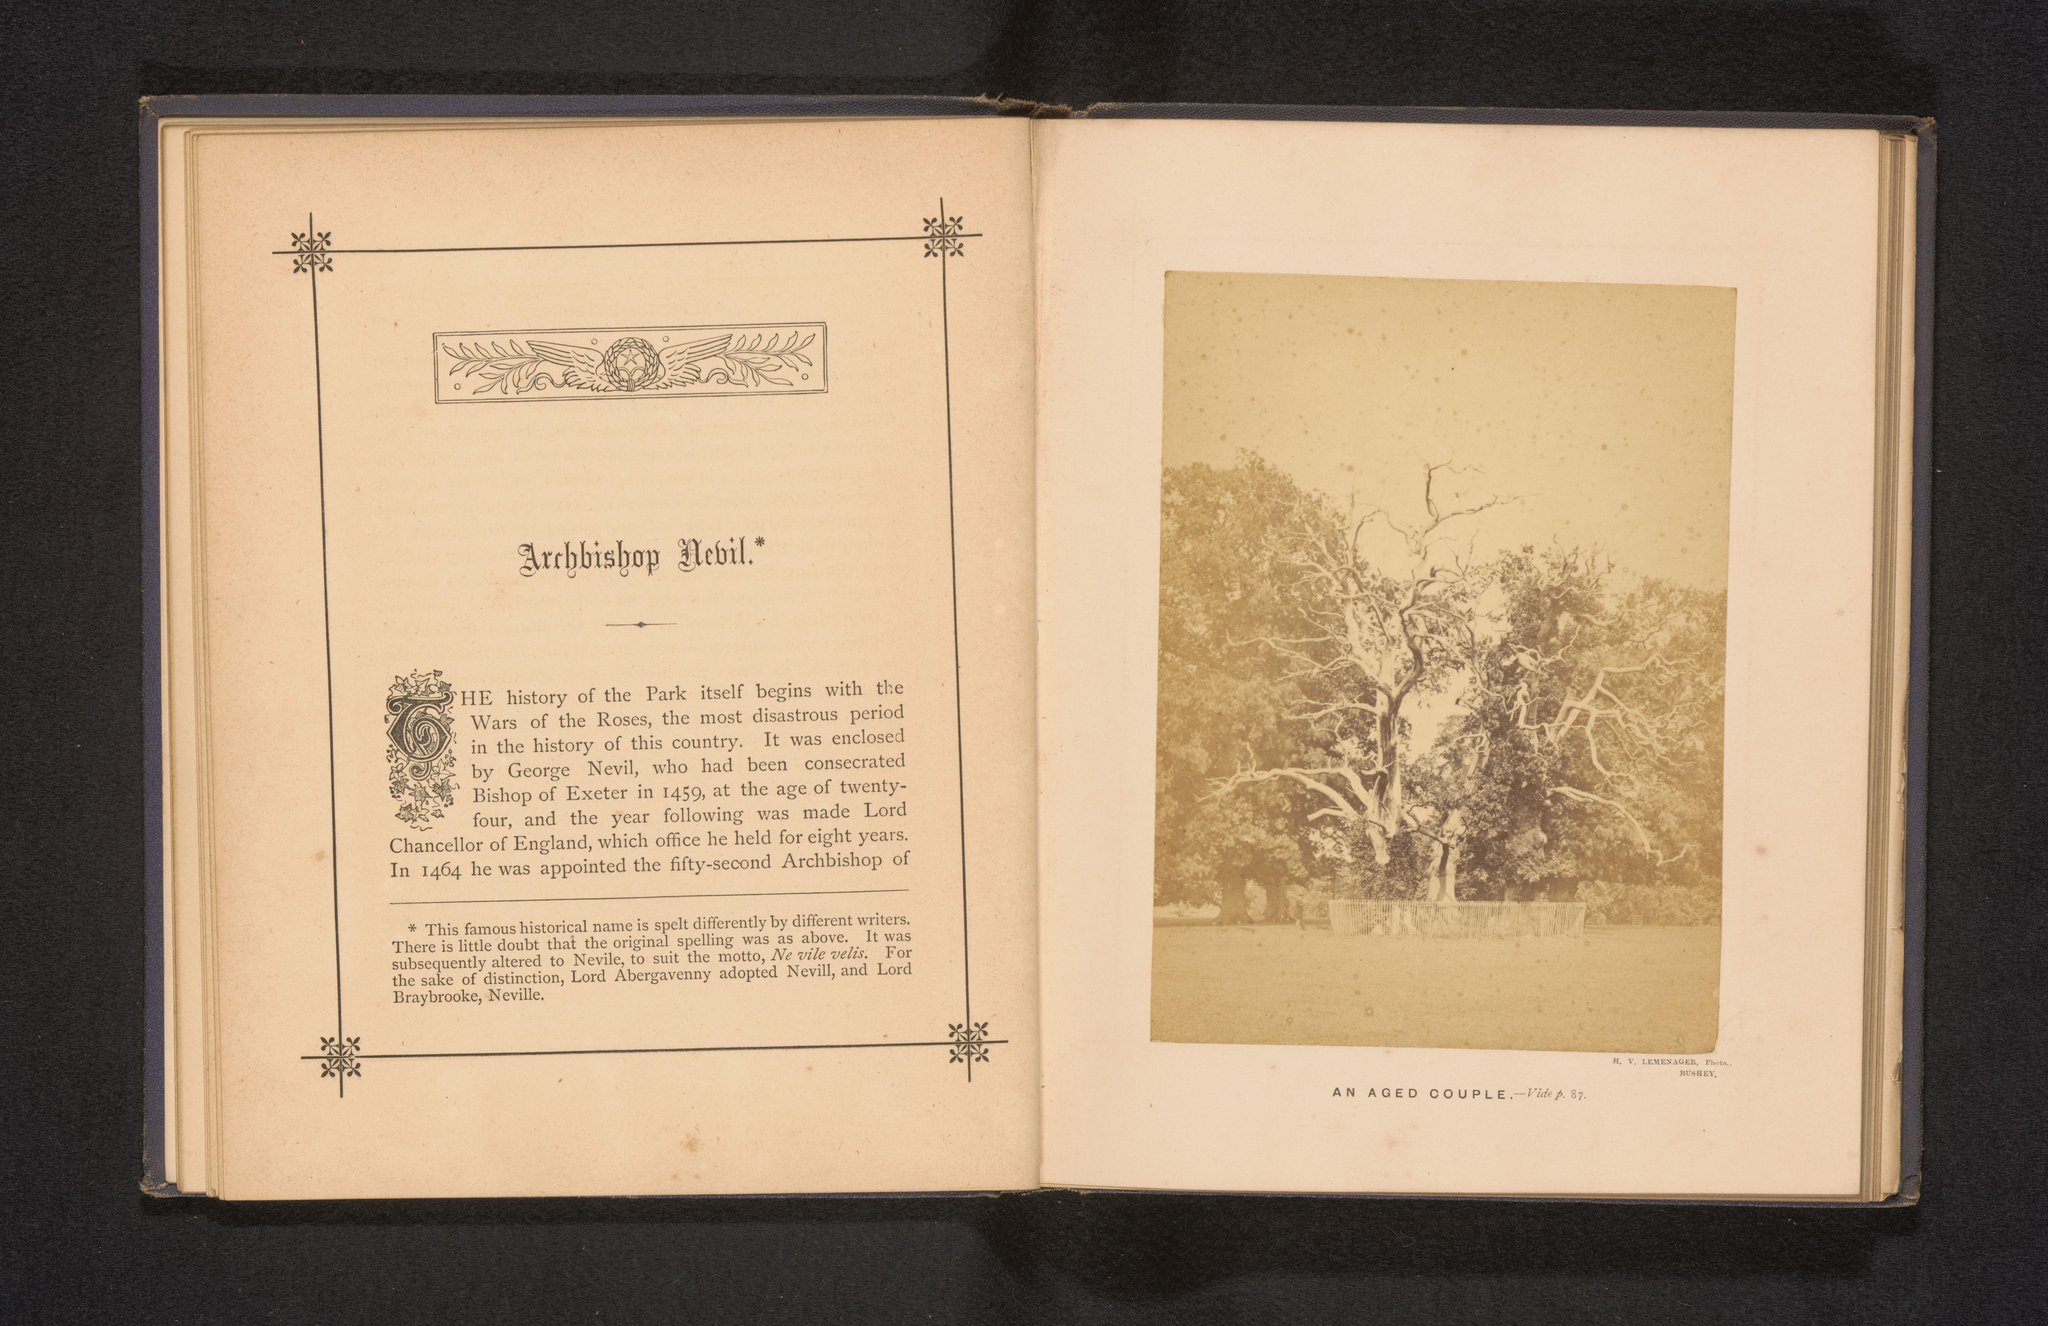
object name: photograph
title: An Aged Couple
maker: henri victor leménager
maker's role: docent, fotograaf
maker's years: 1822-1912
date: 1866-1871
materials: photographic support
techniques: albumen print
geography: rickmansworth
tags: trees: willow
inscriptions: inscription: ‘Vide p. 87.’